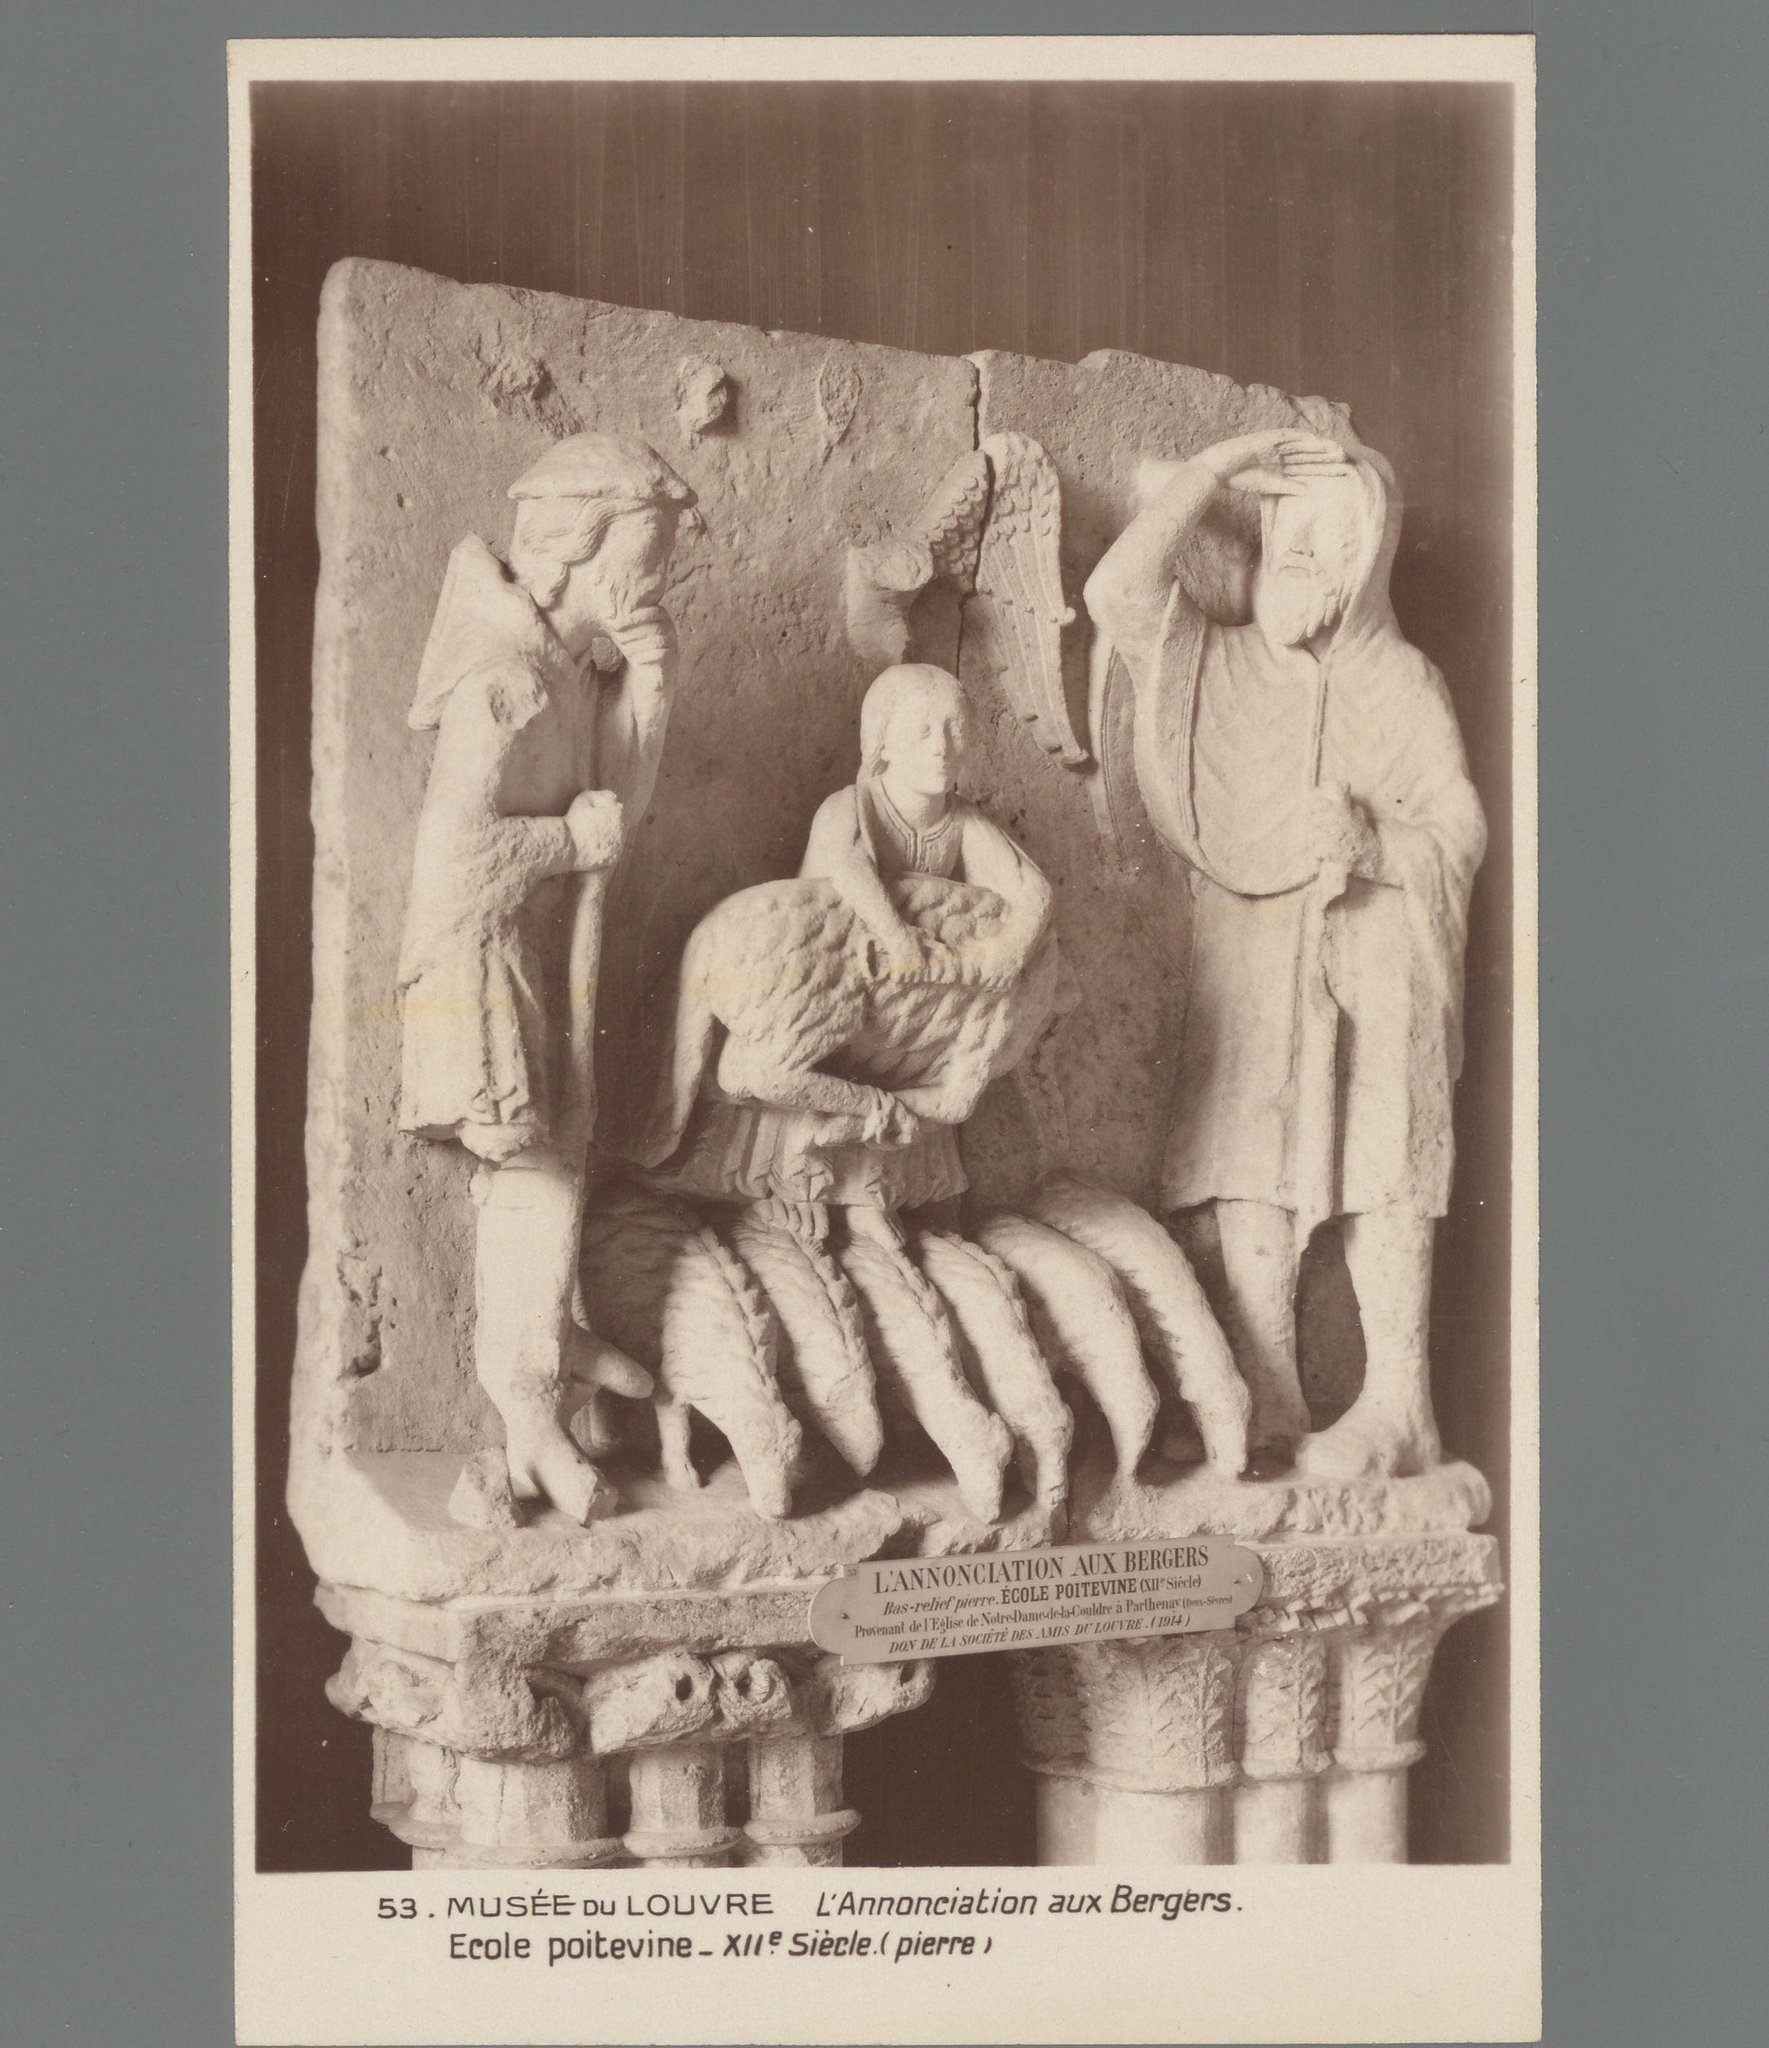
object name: ansichtkaart, prentbriefkaart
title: Musée du Louvre - L'Annonciation aux Bergers. Ecole poitevine XIIe Siècle (pierre)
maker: Anonymous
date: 1903-1930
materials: paper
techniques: gelatin silver print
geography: paris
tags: statues, paintings, etc. ~ objects of worship in roman religion, permanent exhibition, museum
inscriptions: collector's mark: ‘AFE v S’